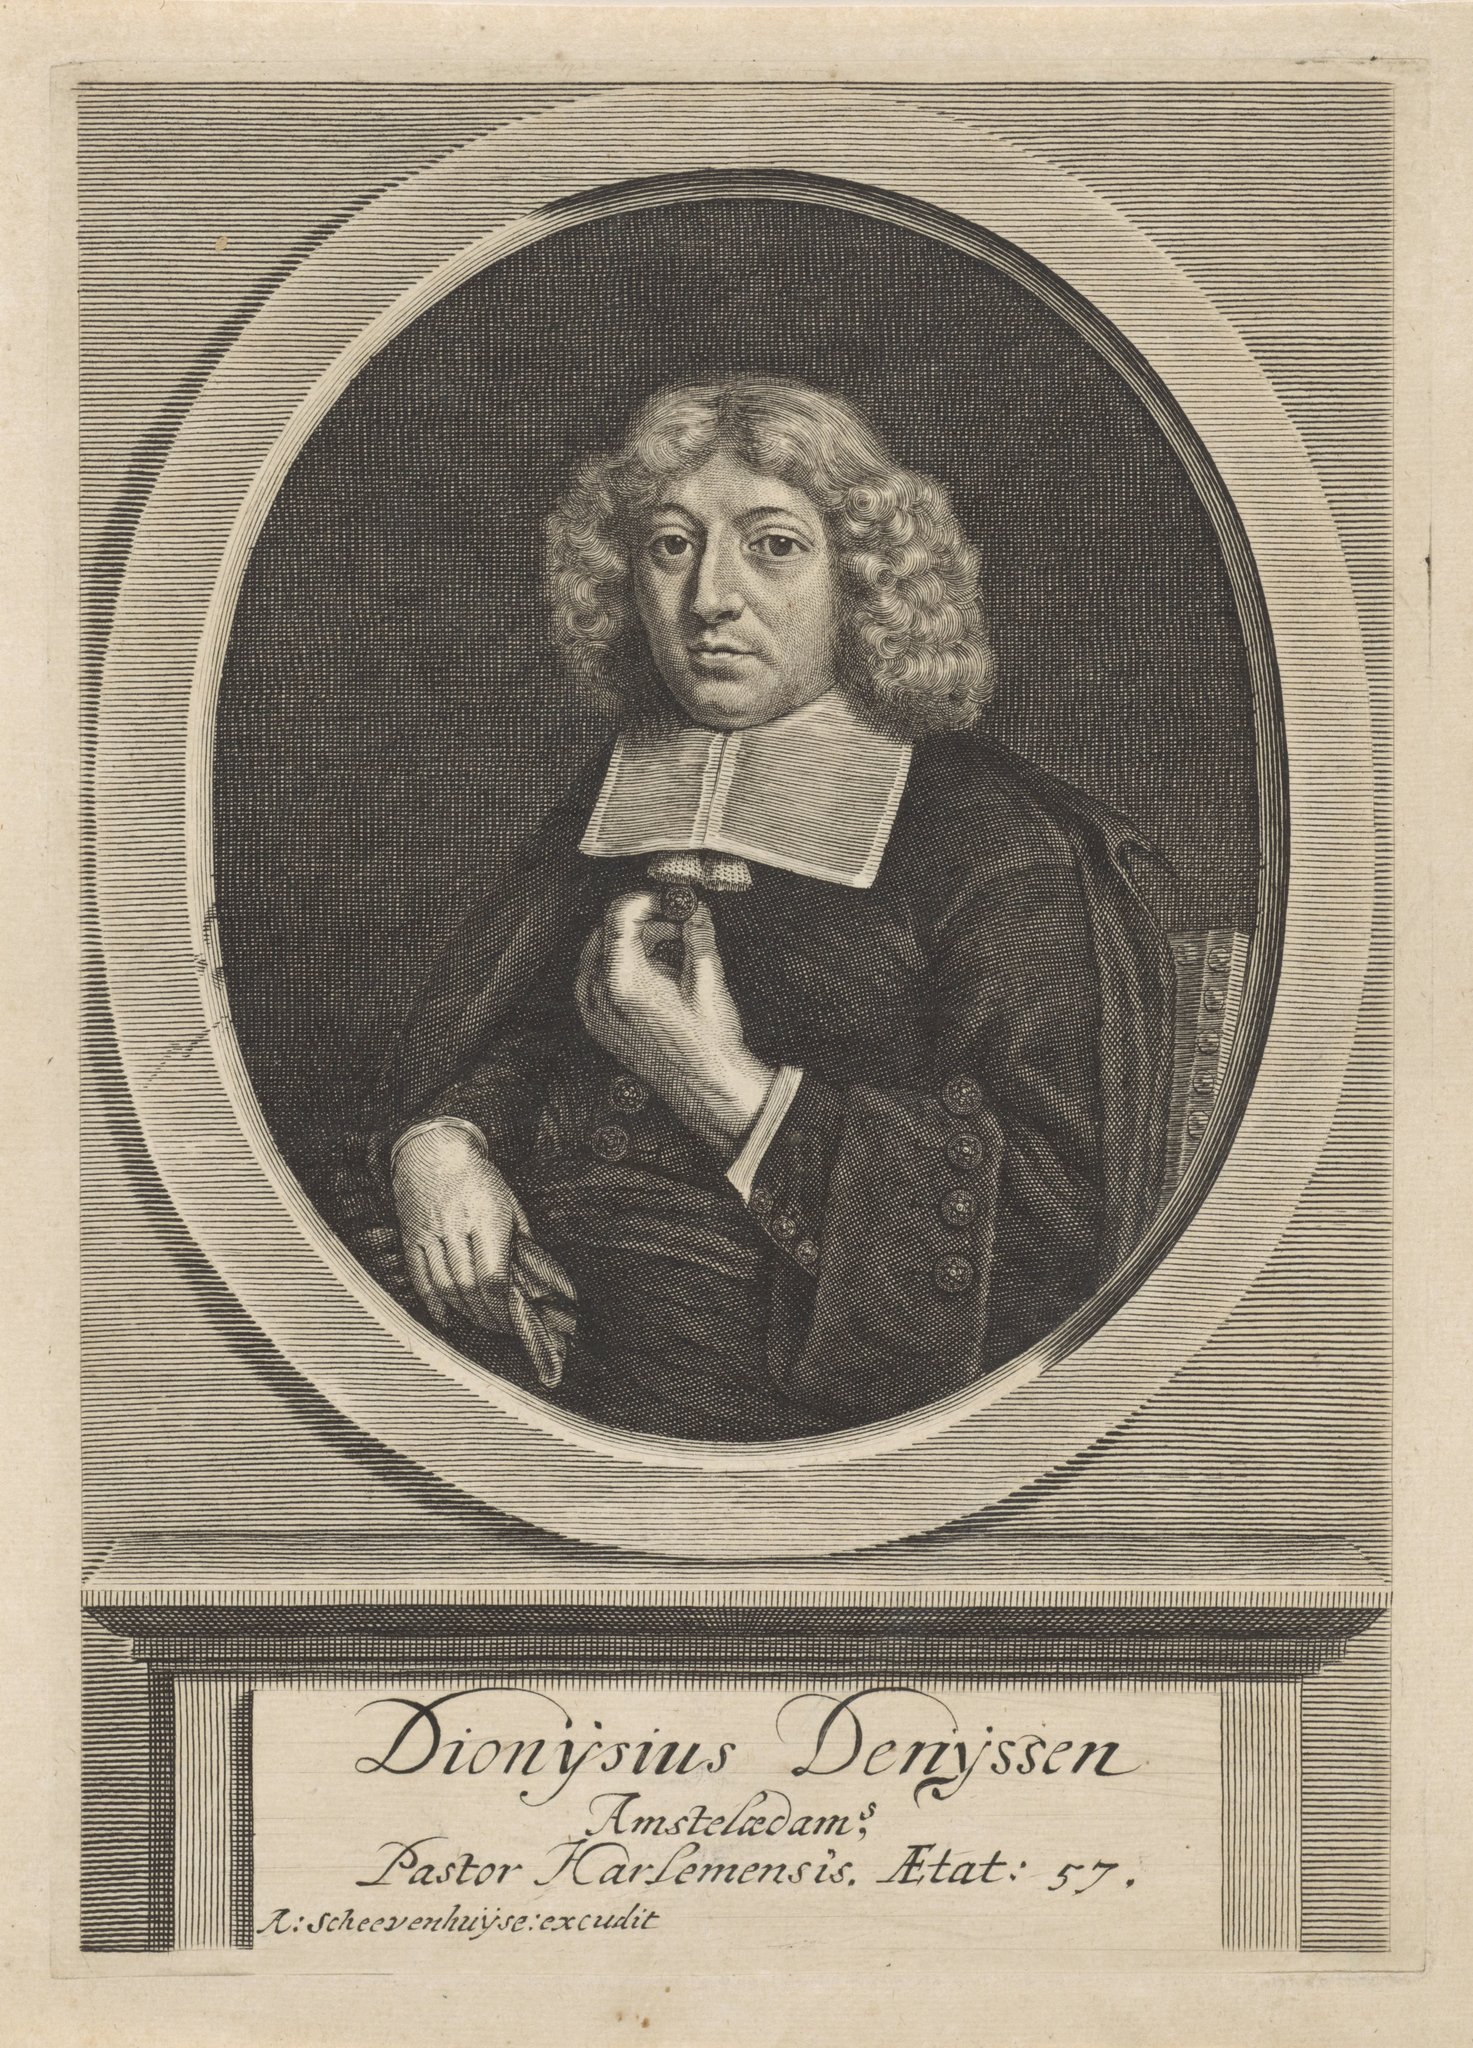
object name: print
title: Portret van Dionysius Denijssen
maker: ambrosius schevenhuysen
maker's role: print maker, publisher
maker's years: -1712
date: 1693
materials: paper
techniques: engraving, etching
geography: haarlem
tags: gloves, mittens, etc., historical persons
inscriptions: collector's mark: Lugt 2228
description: Portret van de Haarlemse predikant Dionysius Denijssen. Hij zit op een stoel en met zijn rechterhand toont hij een knoop van zijn kleding. In zijn linkerhand heeft hij een paar handschoenen. Het portret is gevat in een omlijsting met onderaan de naam, functie en leeftijd van de geportretteerde.